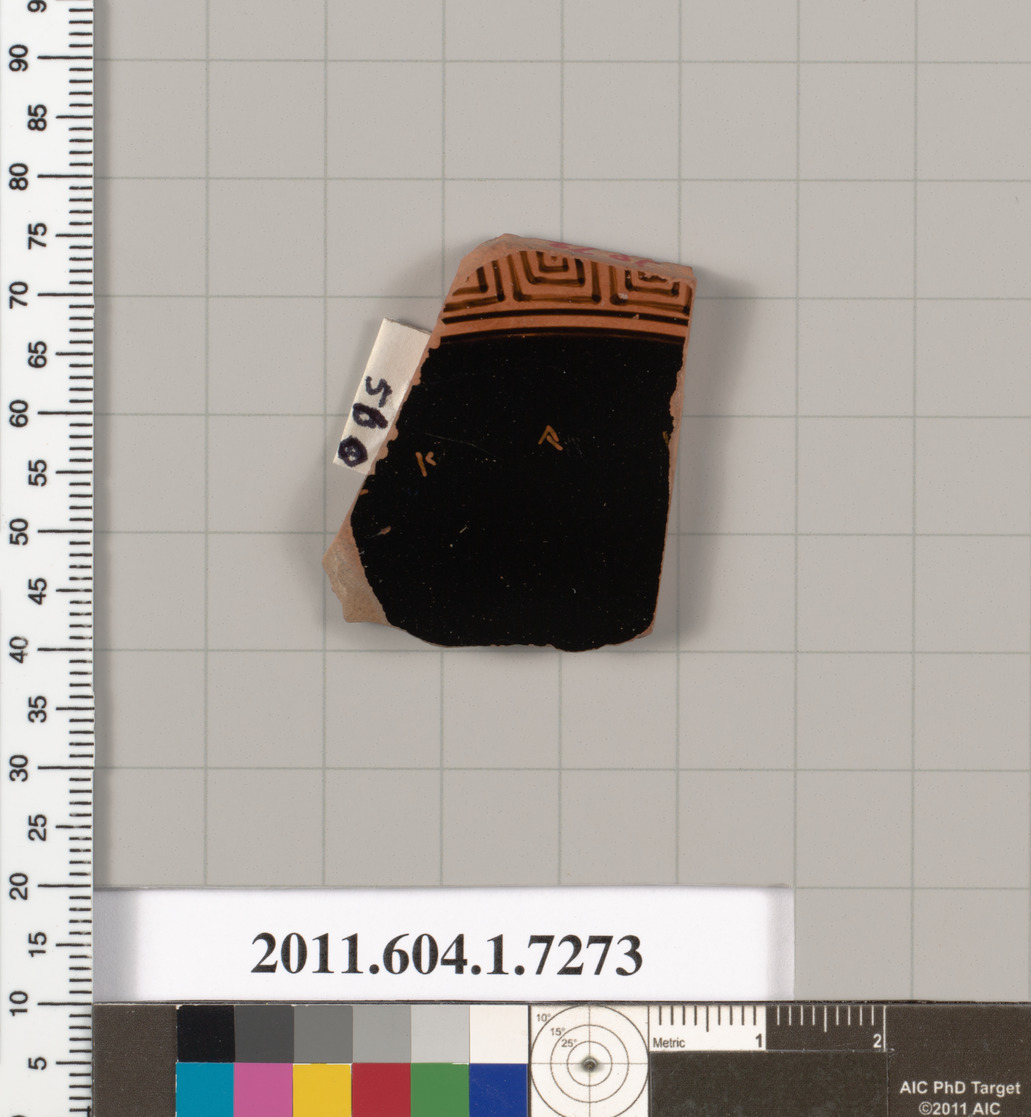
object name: kylix fragment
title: Terracotta fragment of a kylix (drinking cup)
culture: greek, attic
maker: makron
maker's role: artist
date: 500-480 BCE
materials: terracotta